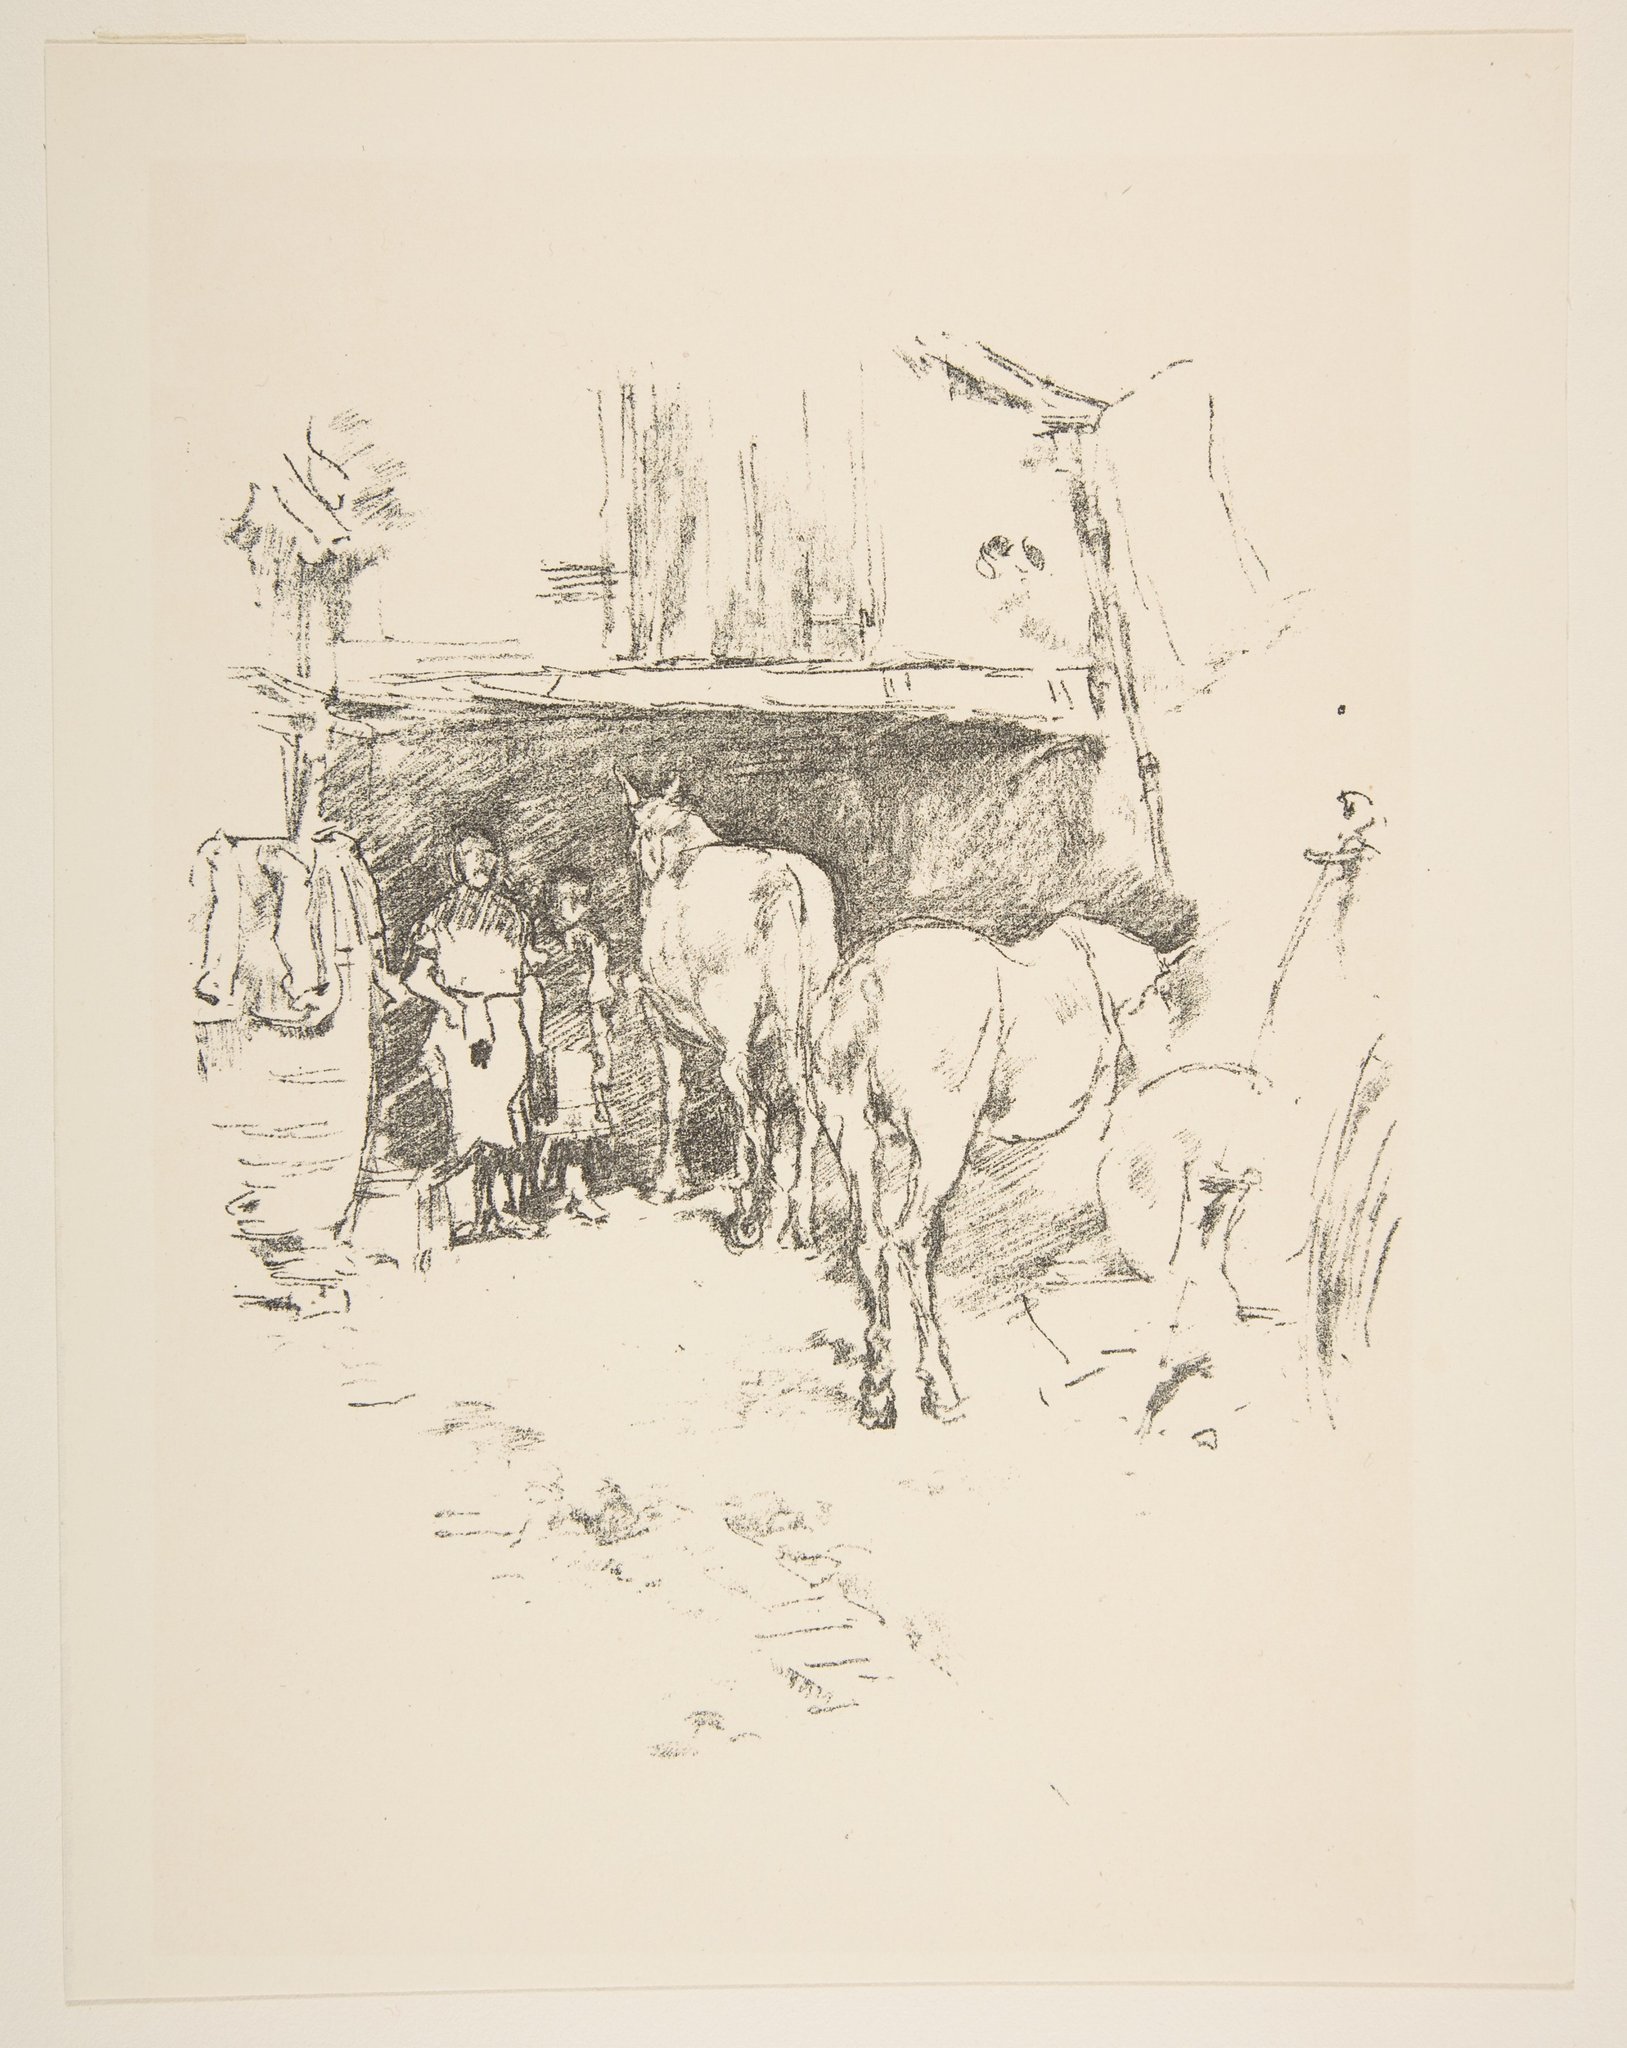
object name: print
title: The Smith's Yard, from "The International Studio"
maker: james mcneill whistler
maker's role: artist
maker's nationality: american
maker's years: 1834-1903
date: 1895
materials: stone, paper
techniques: printing, lithography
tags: men,horses